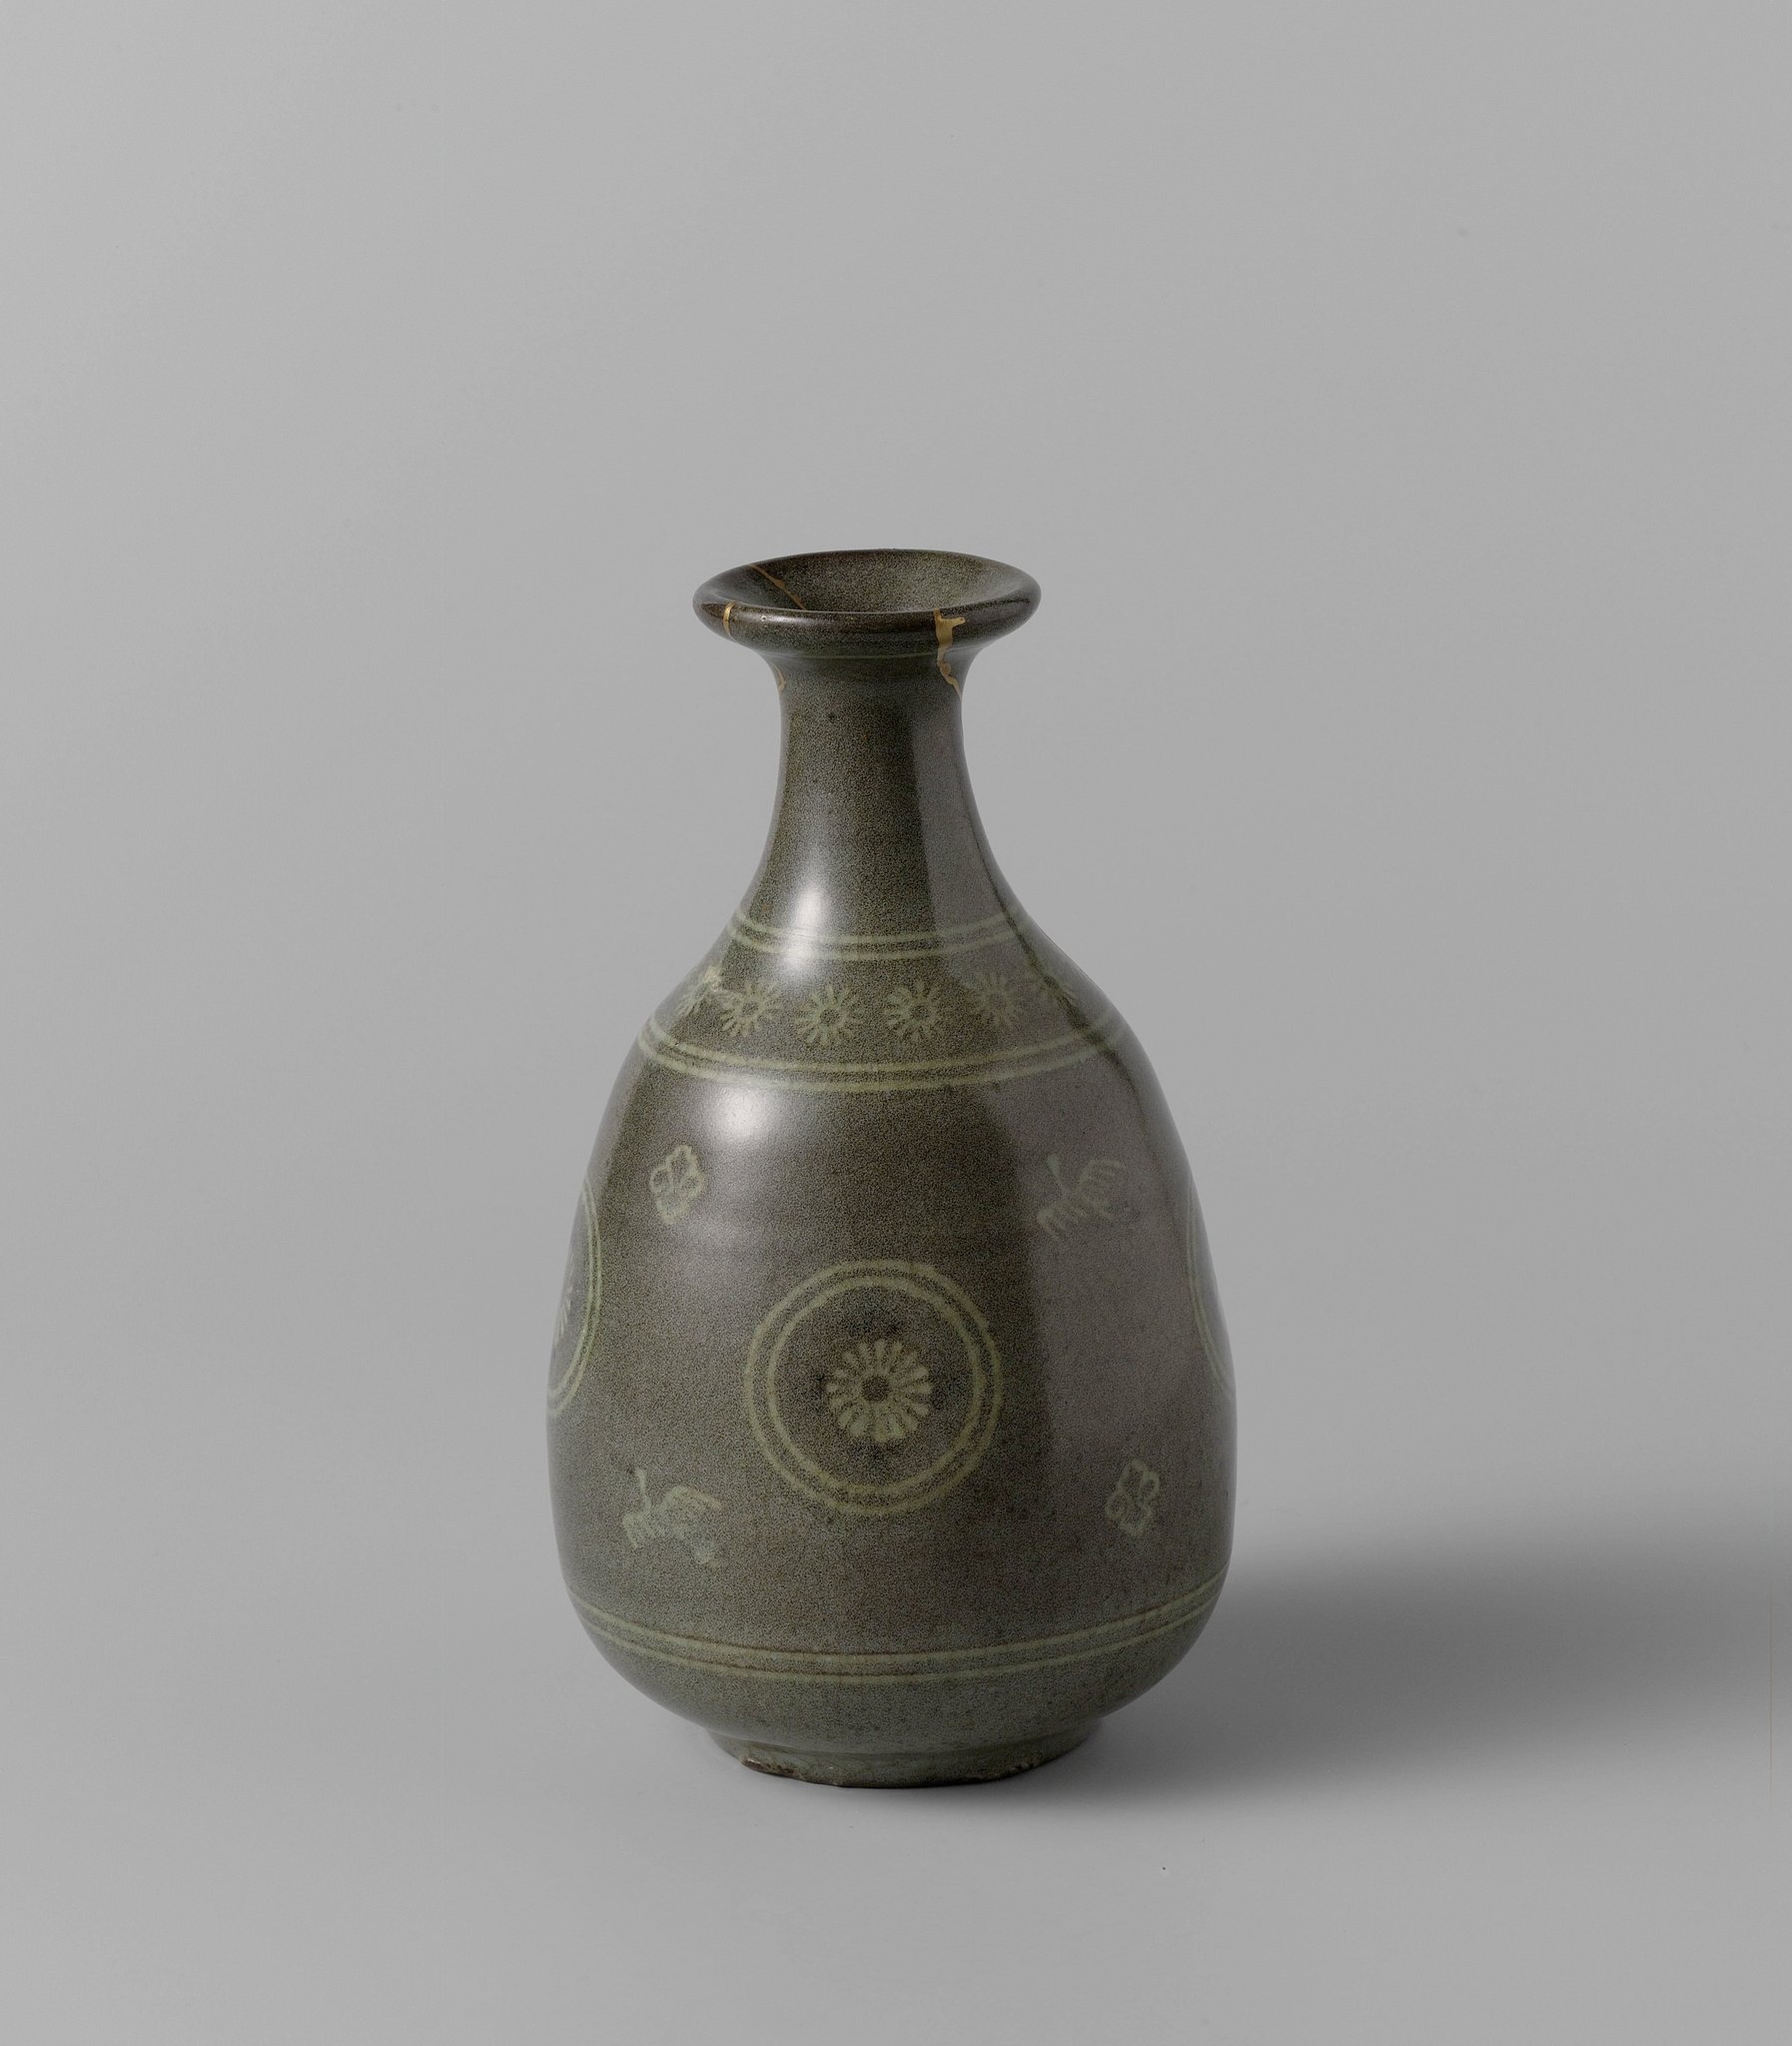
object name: vase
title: Bottle vase with a stylized flowers in medallions, birds and ornamental borders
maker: Anonymous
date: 1600-1800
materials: glaze, paint, stoneware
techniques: inlay, turning, vitrification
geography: karatsu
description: Flesvormige vaas van steengoed, met wit inlegwerk bedekt met een celadongroen-glazuur. De vaas heeft een eivormig lichaam en een smalle, naar boven toe uitlopende hals. Op de buik viermaal een gestileerde bloem in een medaillon met daartussen telkens een vogel en een blad. Op de schouder een band met gestileerde bloemen. De vaas heeft enkele barsten die gerestaureerd zijn met goudlak. Karatsu.